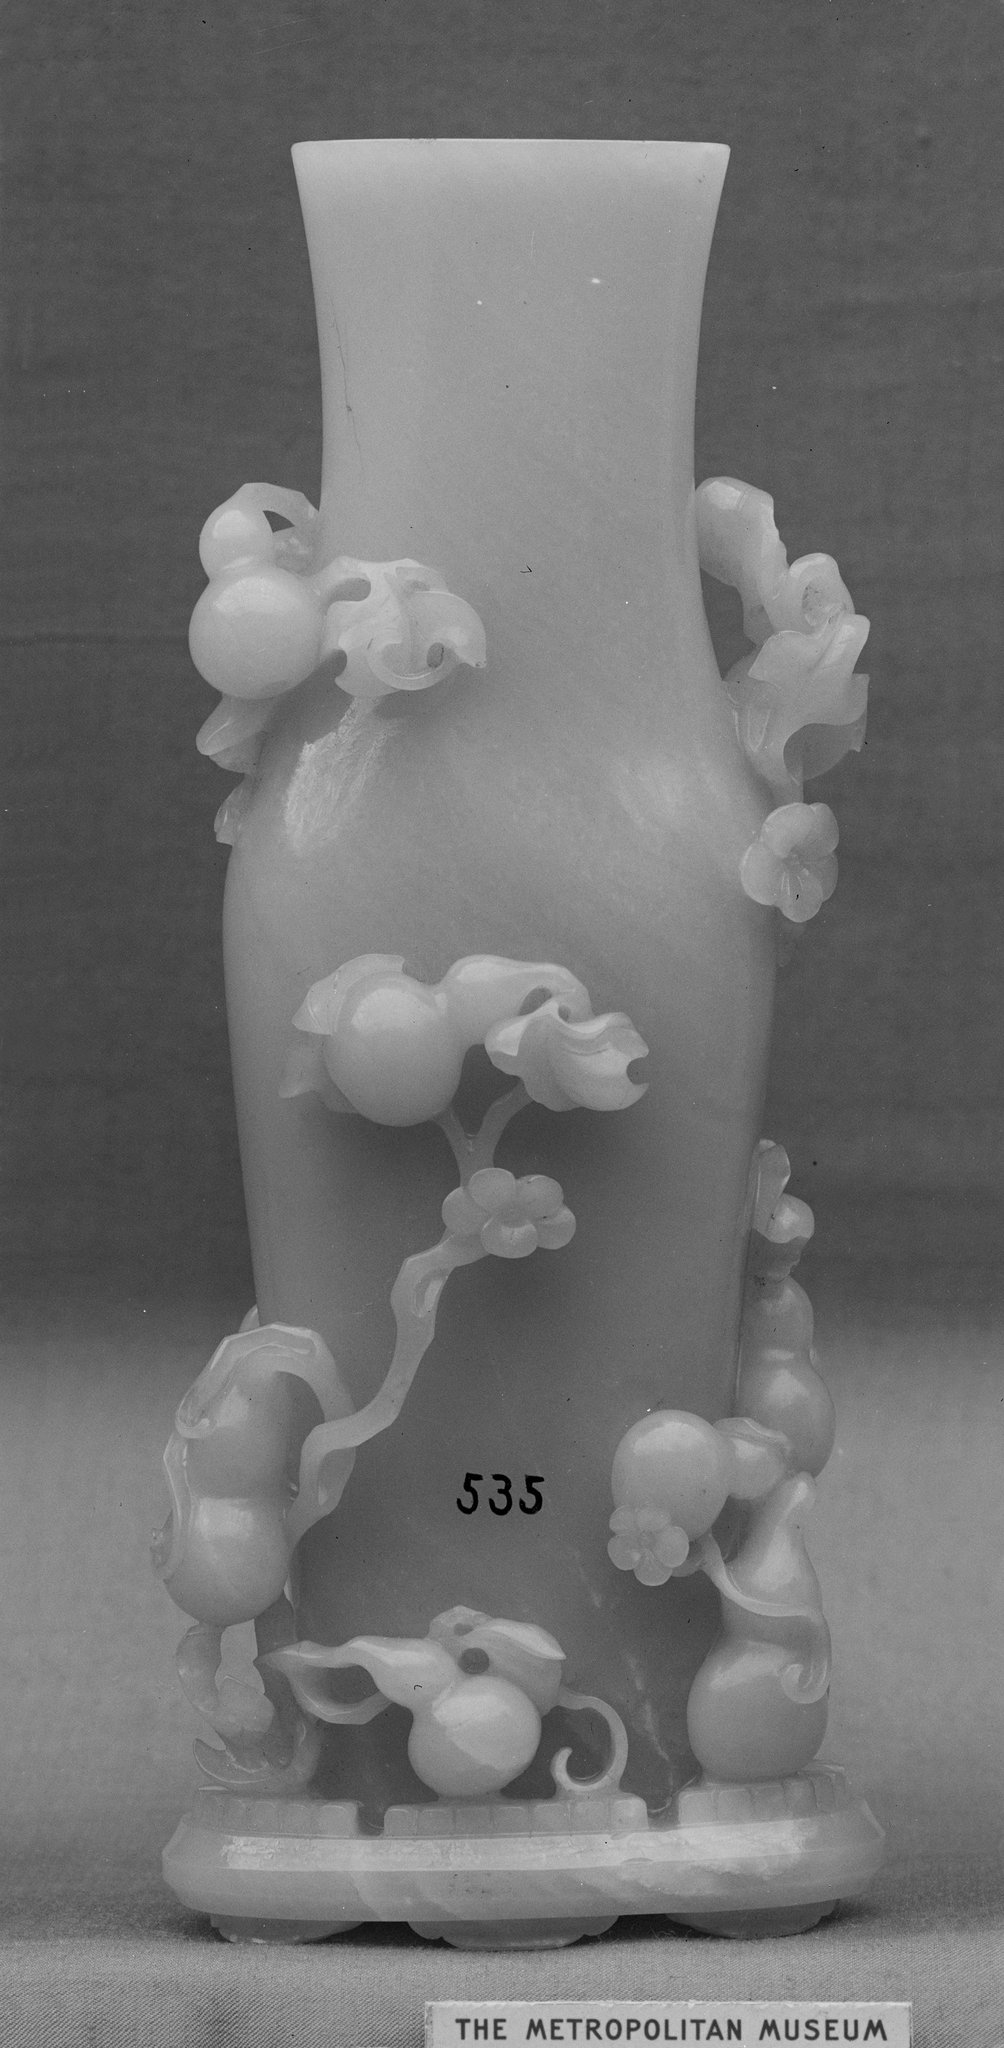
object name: vase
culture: chinese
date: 1736-1795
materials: jade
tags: flowers